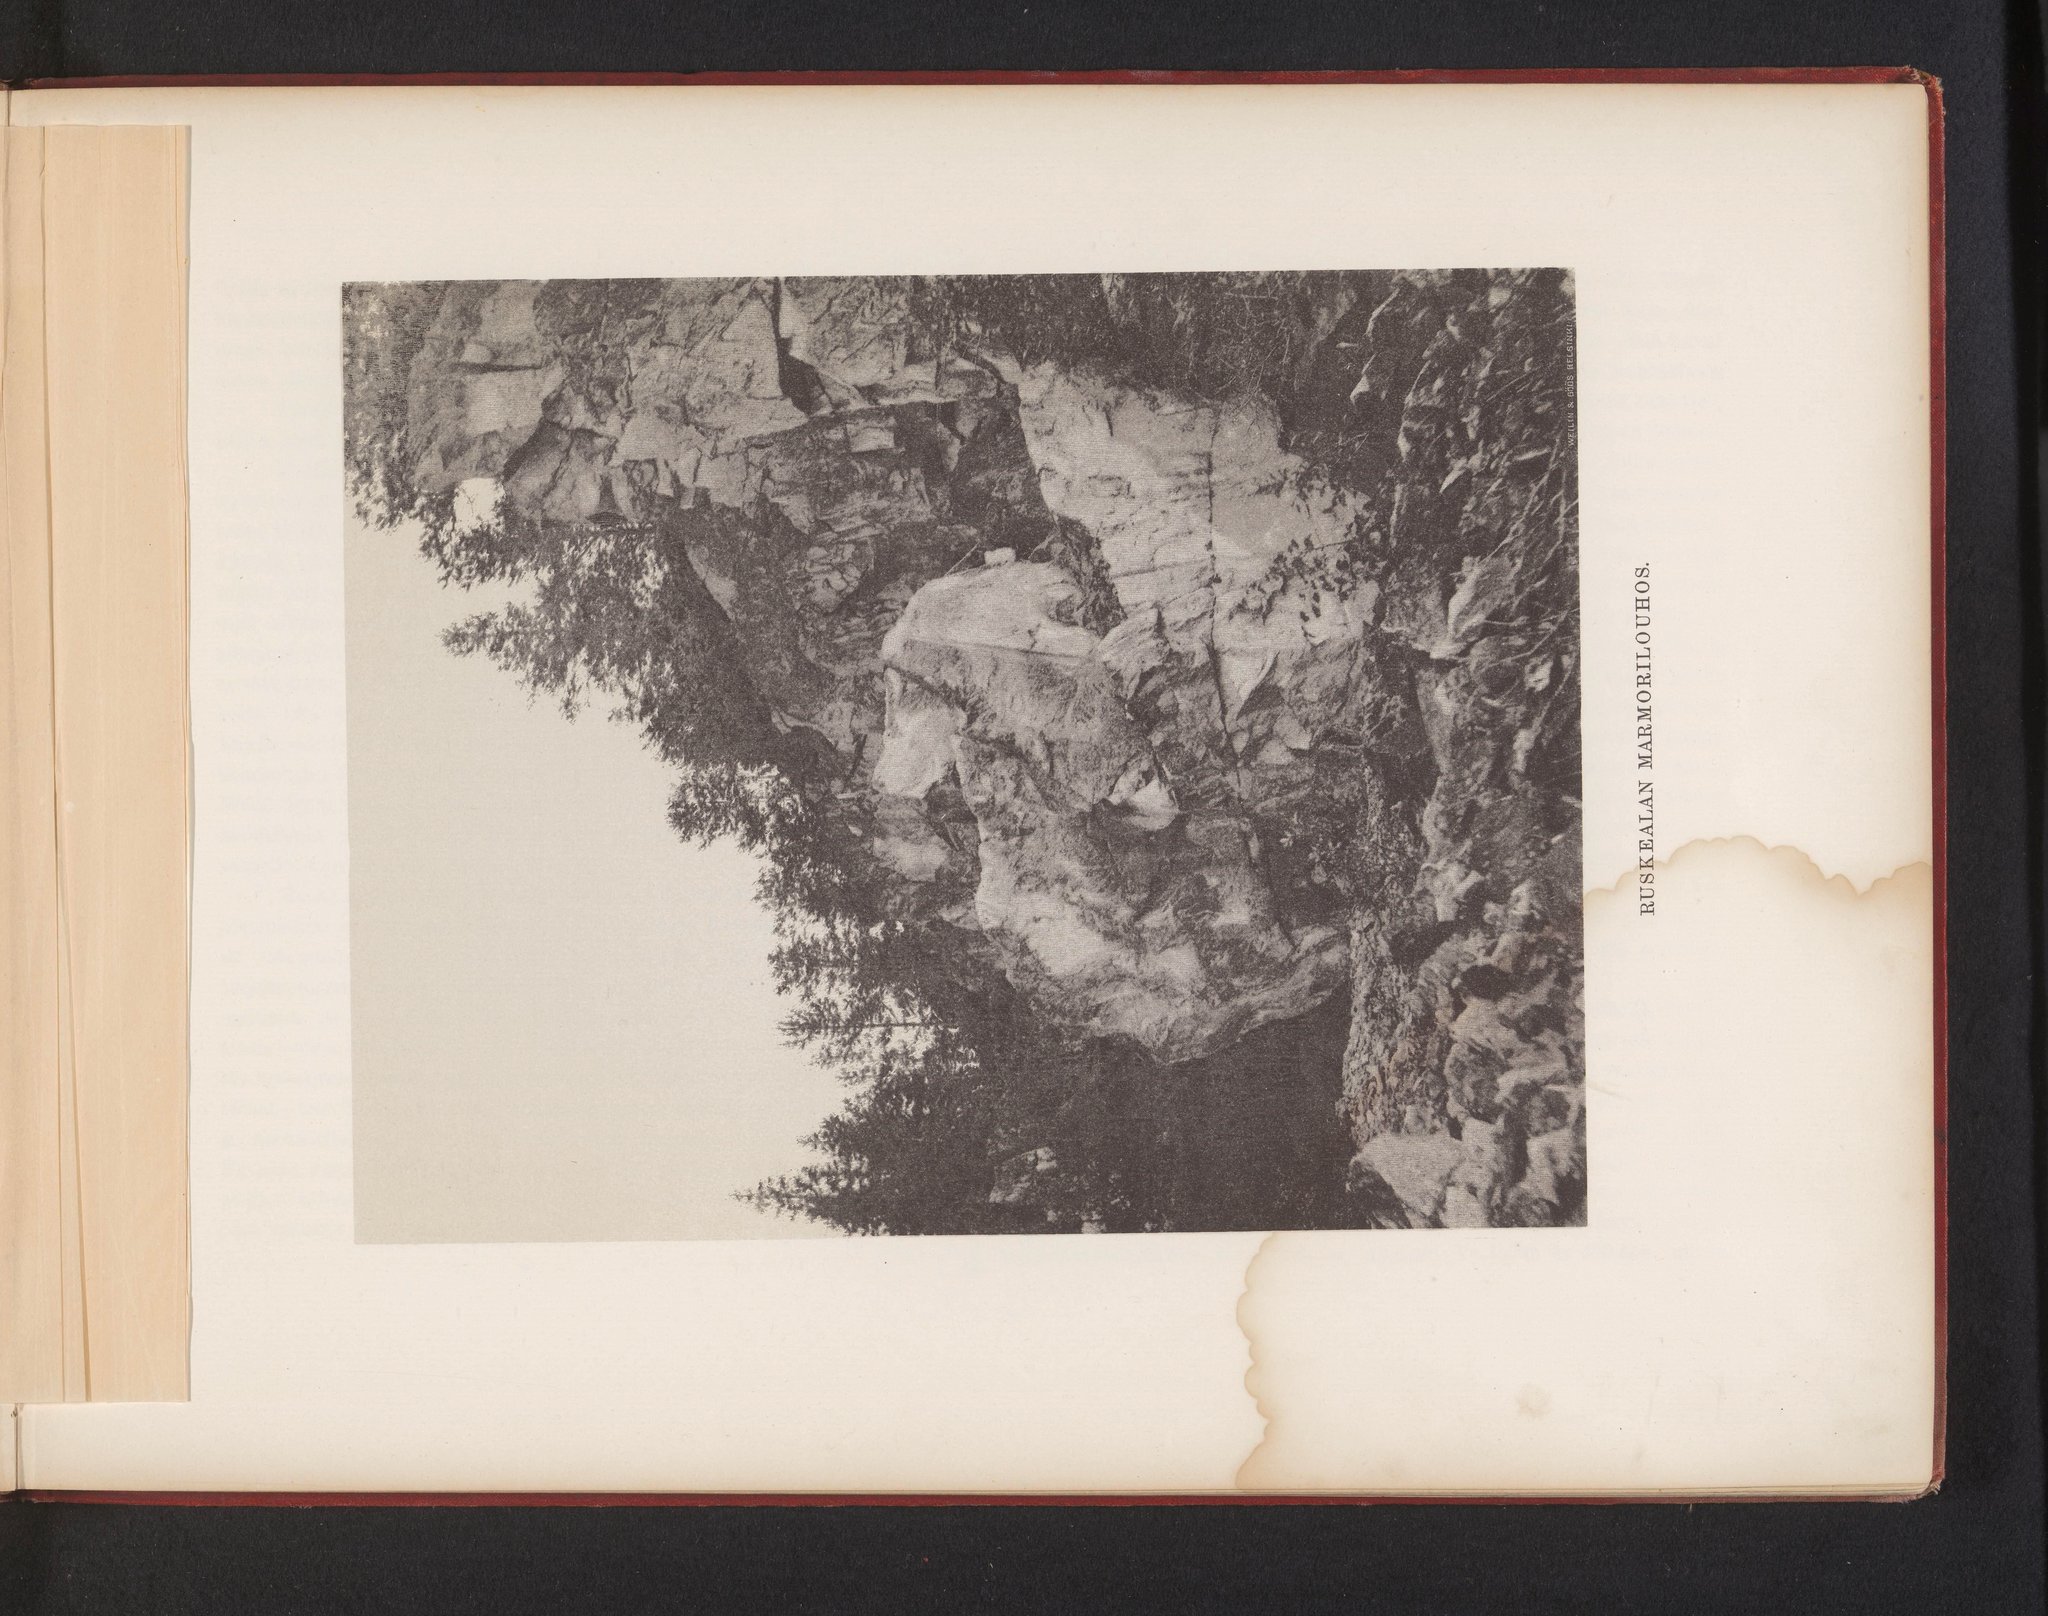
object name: photomechanical print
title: Rotsen in Ruskeala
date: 1888-1893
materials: paper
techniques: autotype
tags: rocks